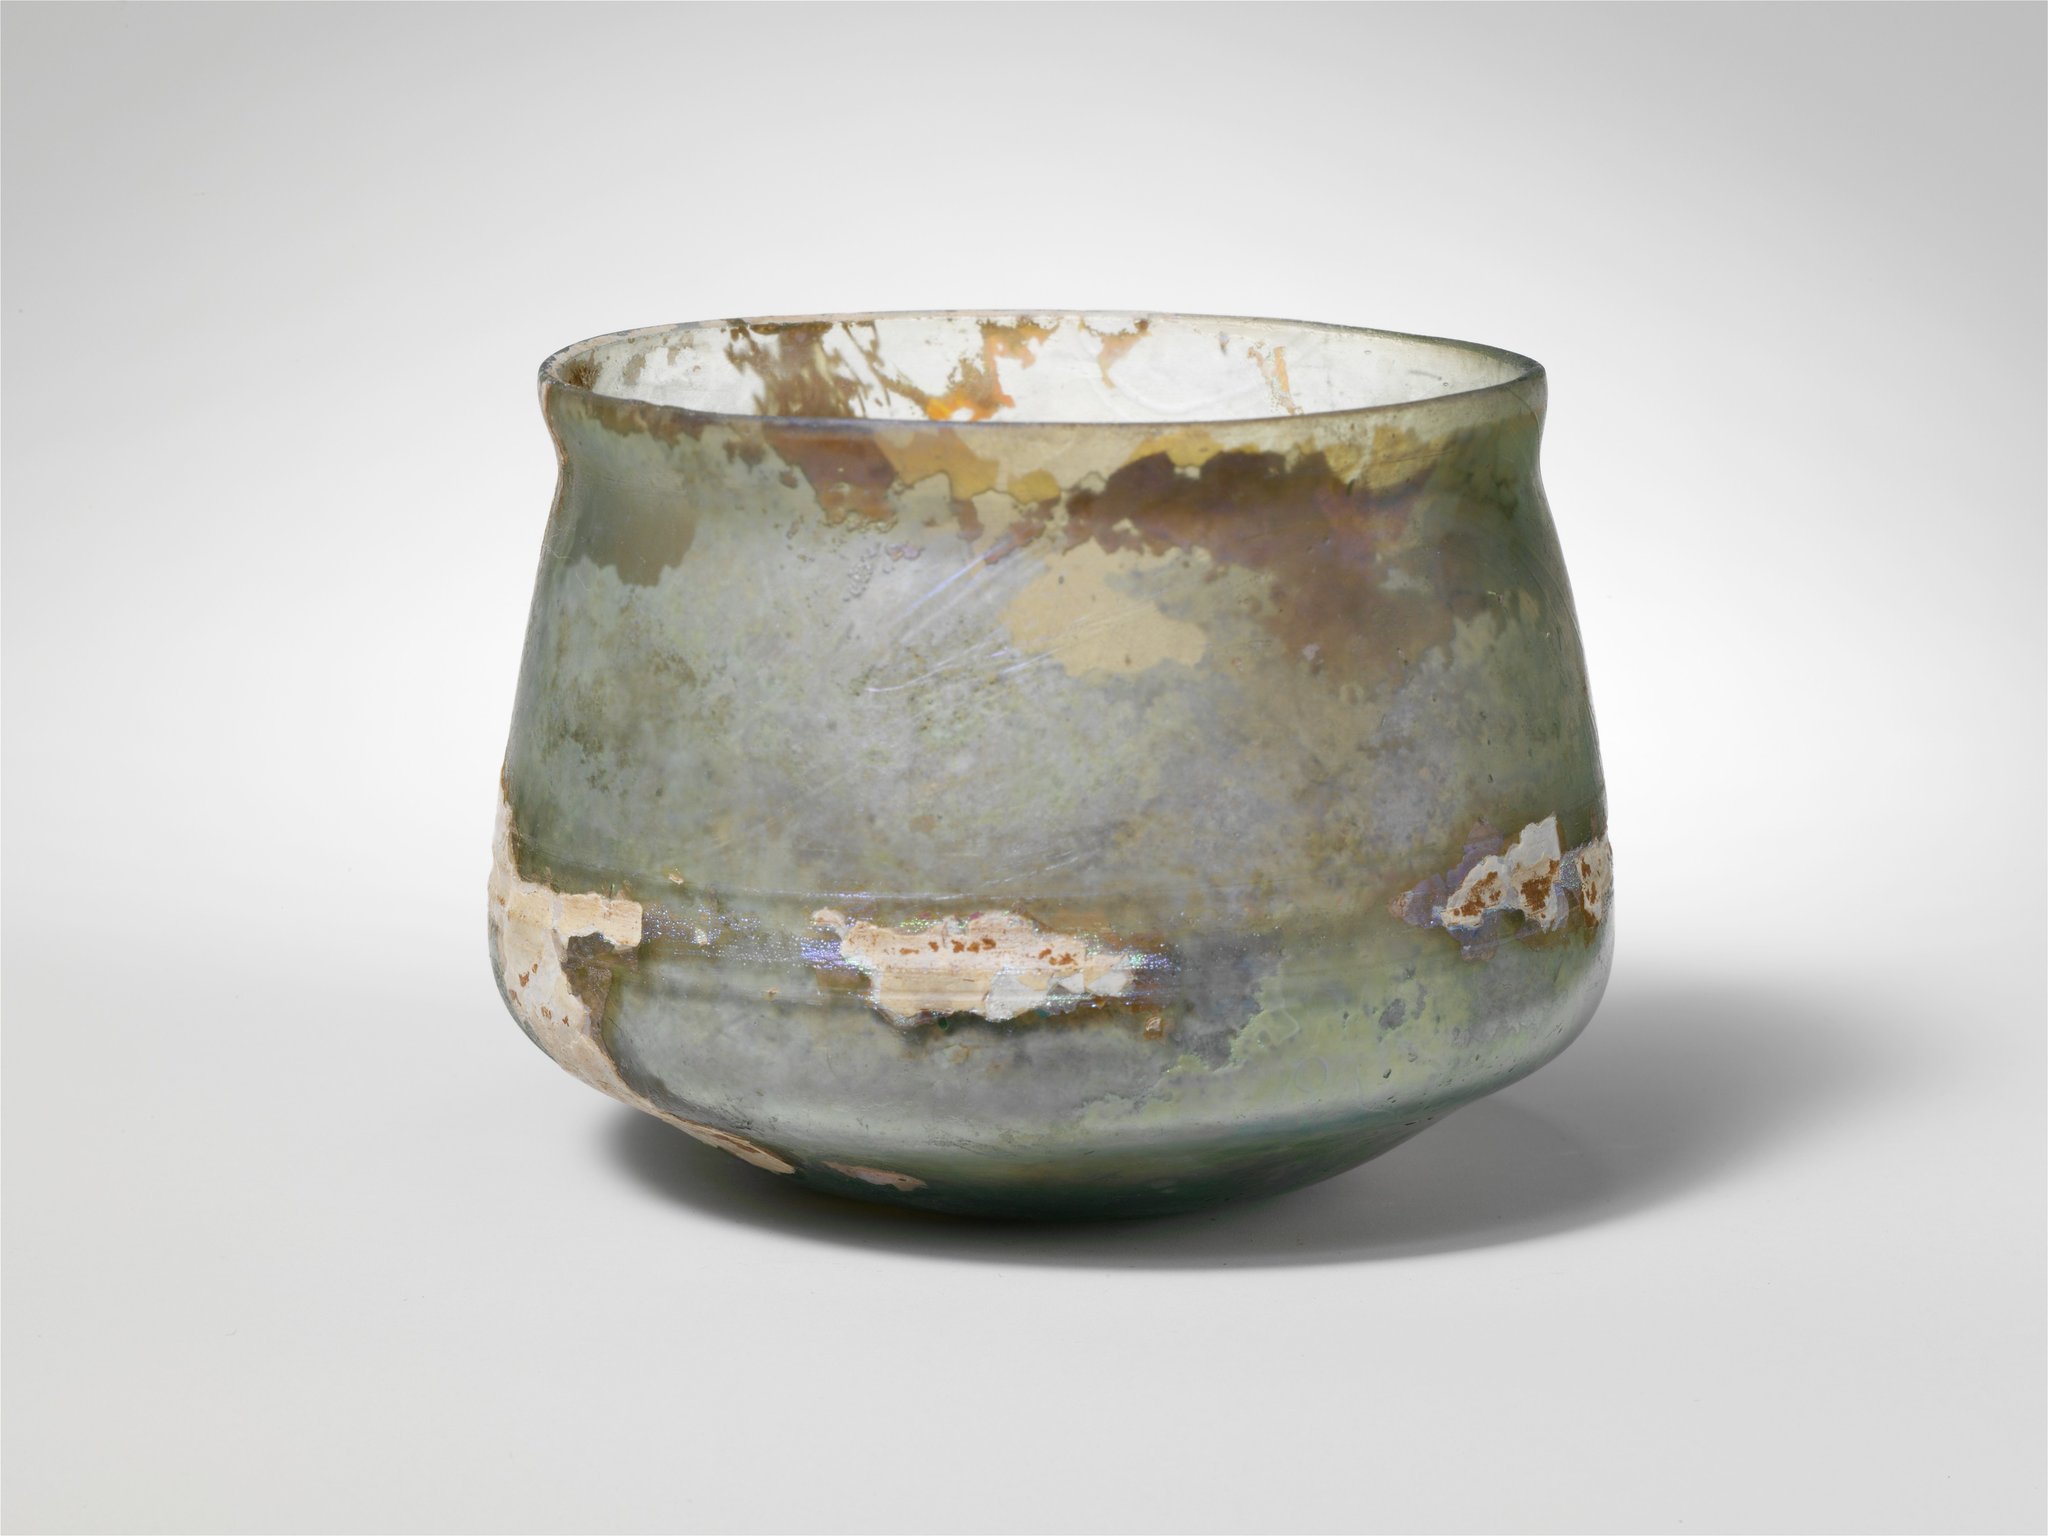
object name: cup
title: Glass cup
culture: roman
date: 201-300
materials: glass